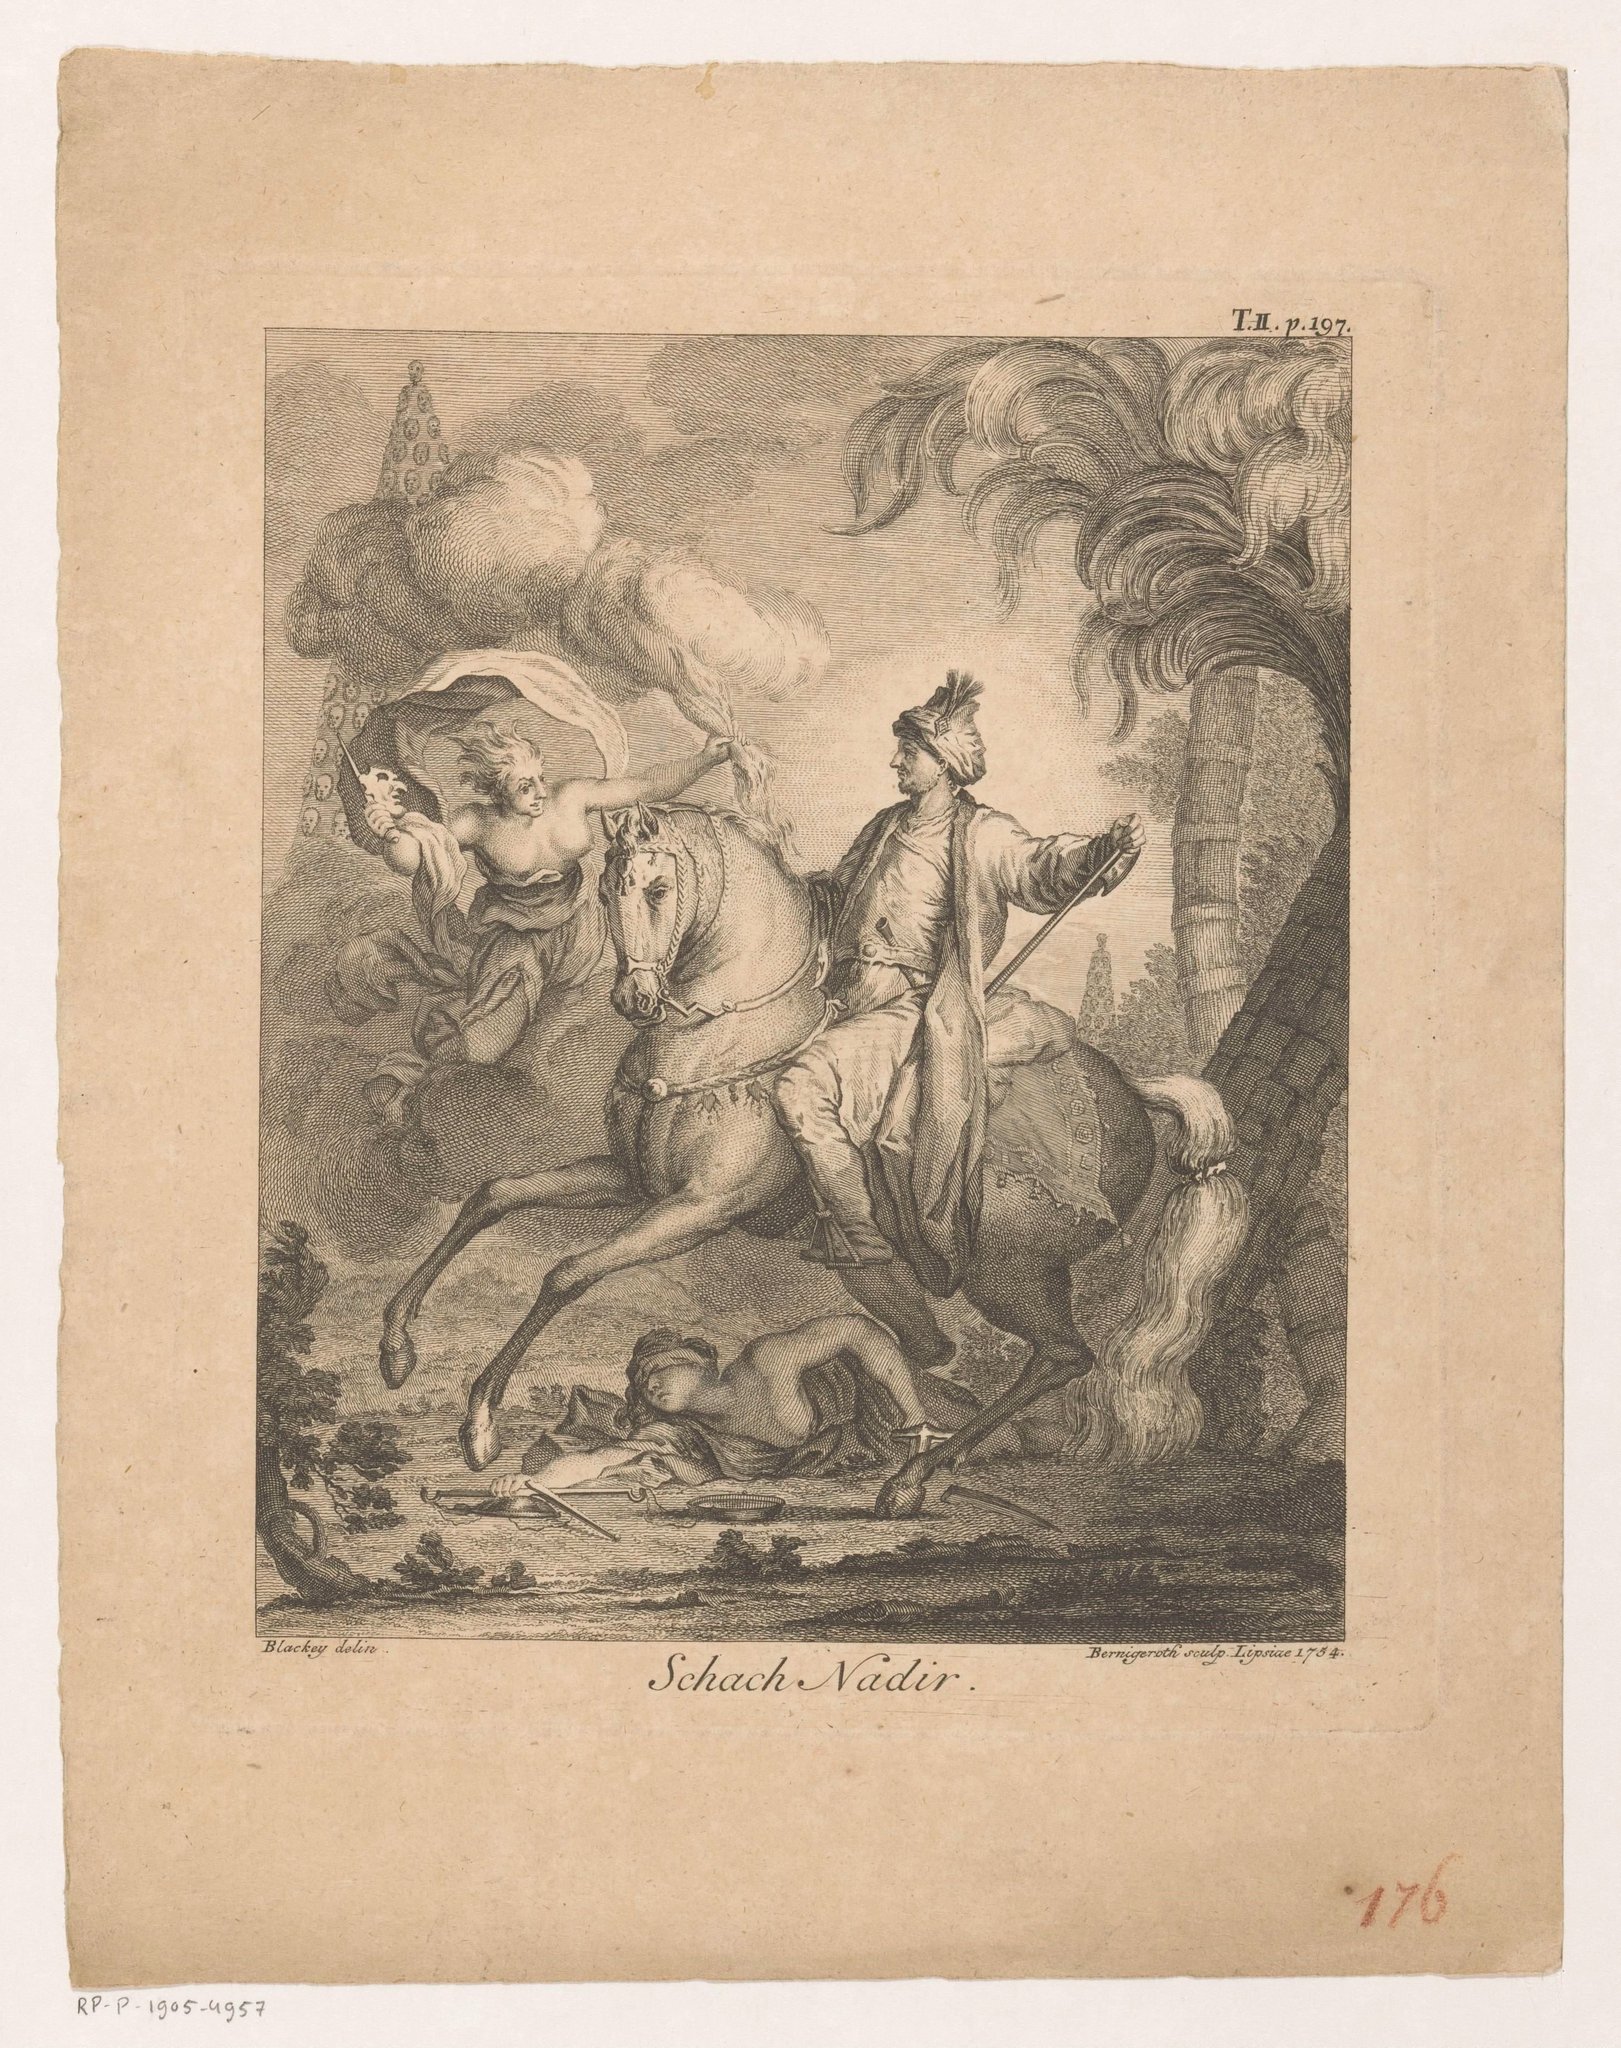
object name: print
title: Ruiterportret van Nadir Sjah Afshar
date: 1754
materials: paper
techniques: etching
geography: leipzig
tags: riding a horse, ass, or mule; rider, horseman, historical persons, justice; 'forza alla giustitia sottoposta', 'giustitia', 'giustitia retta', 'giustitia rigorosa', 'impietà e violenza soggetta alla giustitia' (ripa), melpomene (one of the muses); 'melpomene' (ripa), death's head, skull (symbol of death)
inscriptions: collector's mark: Lugt 2228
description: Achter de ruiter ligt Justitie verslagen op de grond. In de achtergrond een piramide van doodshoofden met daarvoor een allegorisch figuur met in haar handen, een dolk en een vlam. Mogelijk stelt zij Malpomene voor, de muze van het treurspel. Rechtsboven genummerd: T II. p. 197.